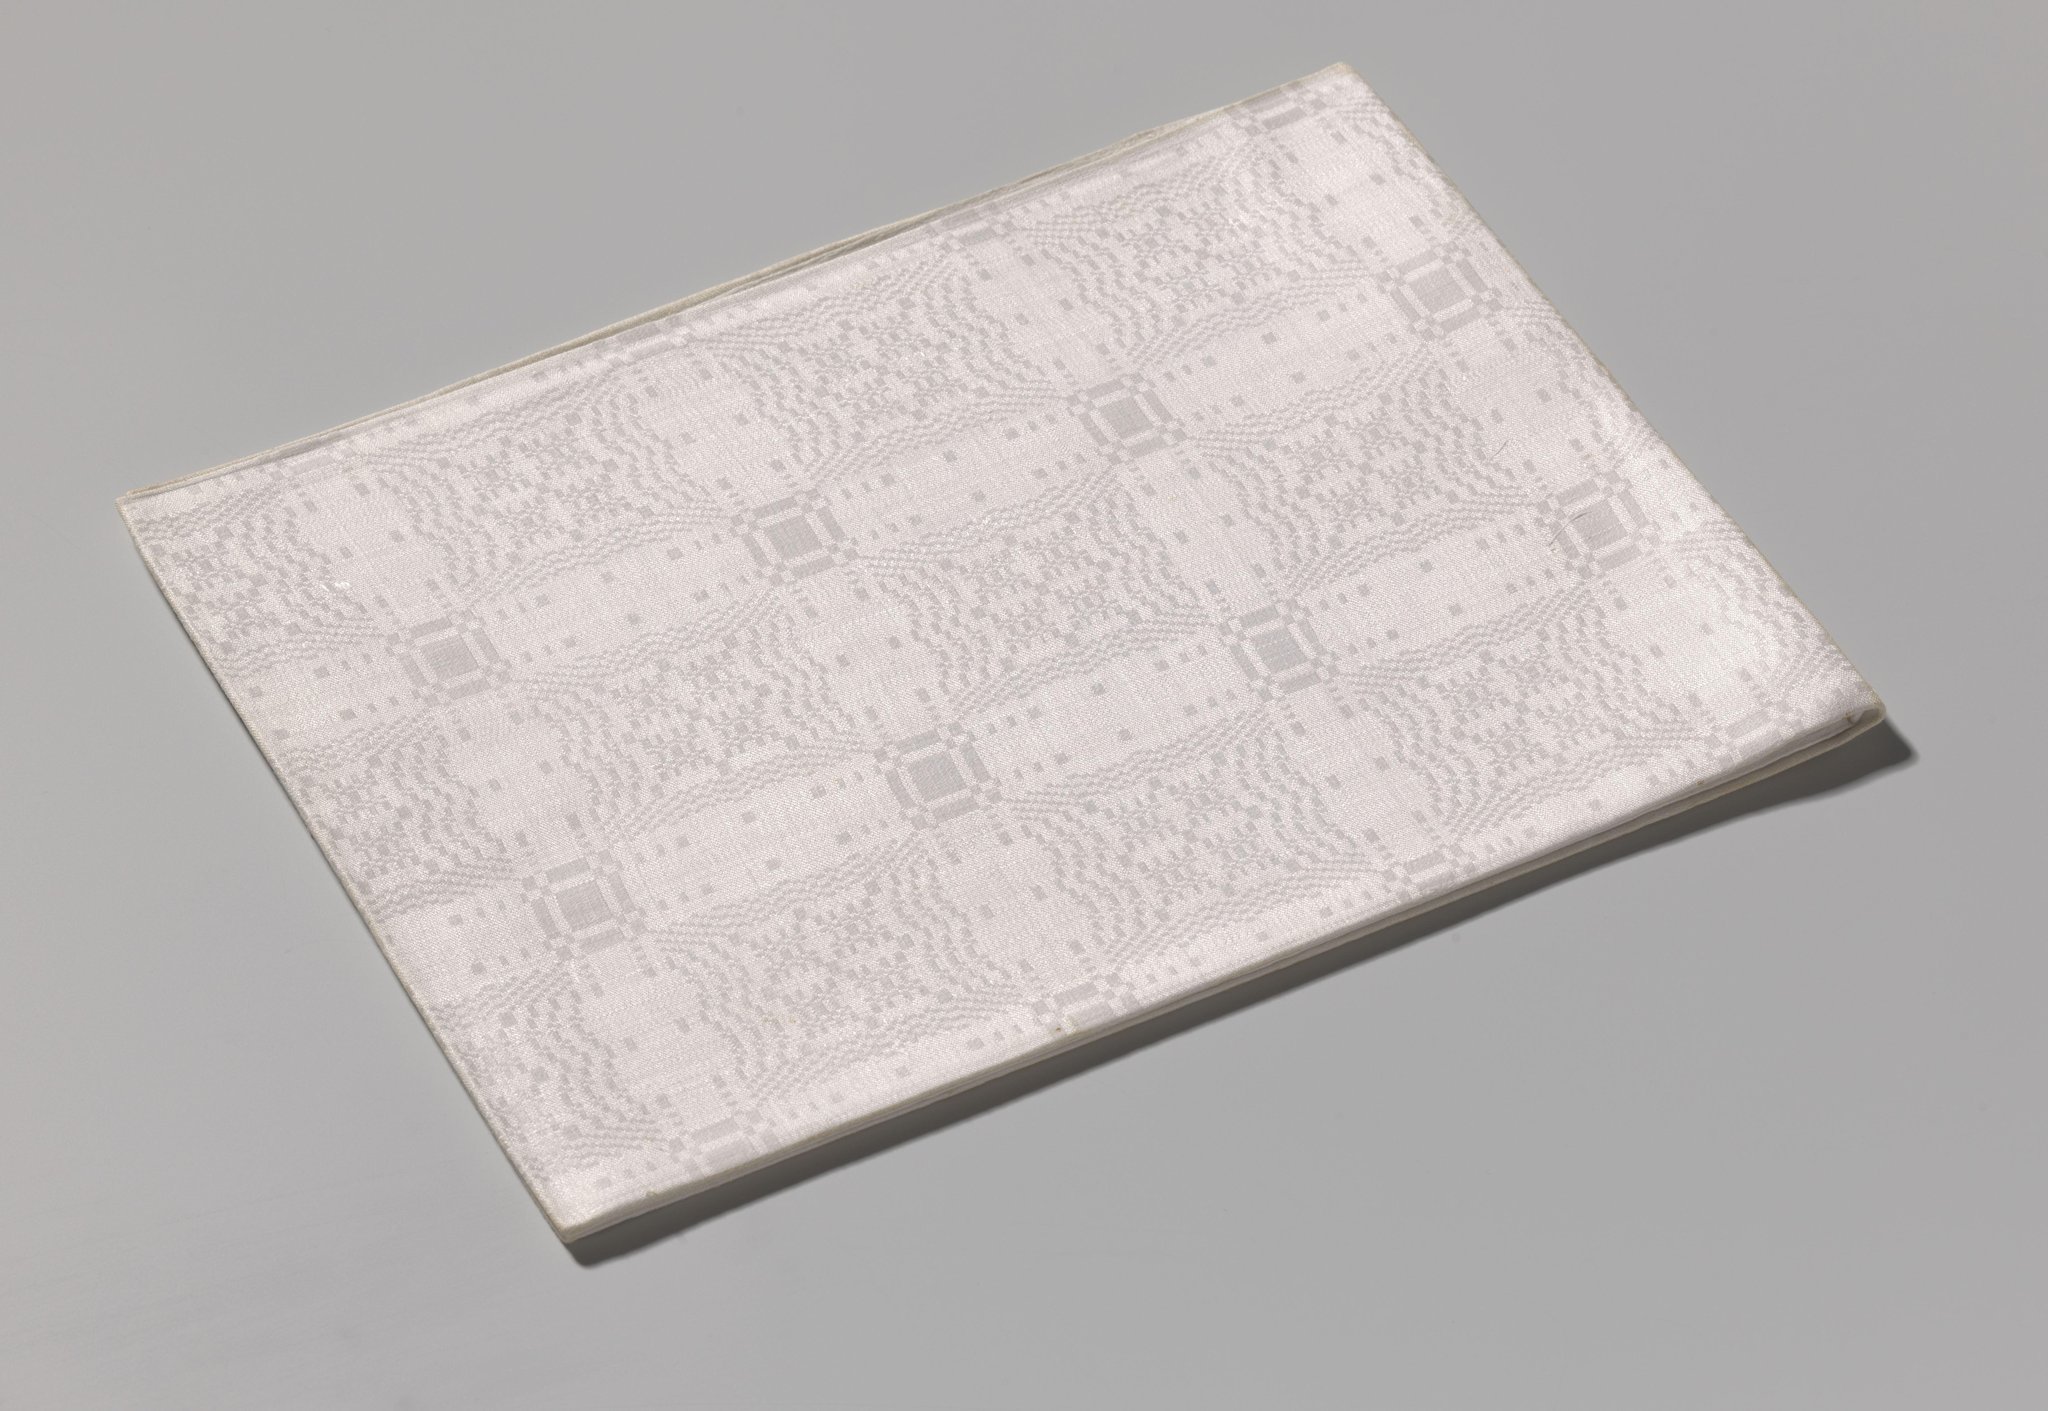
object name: napkin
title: Servet van linnen met pellenpatroon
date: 1400-1950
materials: linen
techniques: peeled fabric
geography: northern netherlands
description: Wit linnendamasten servet met pellenpatroon, merk kroon IS en 96.